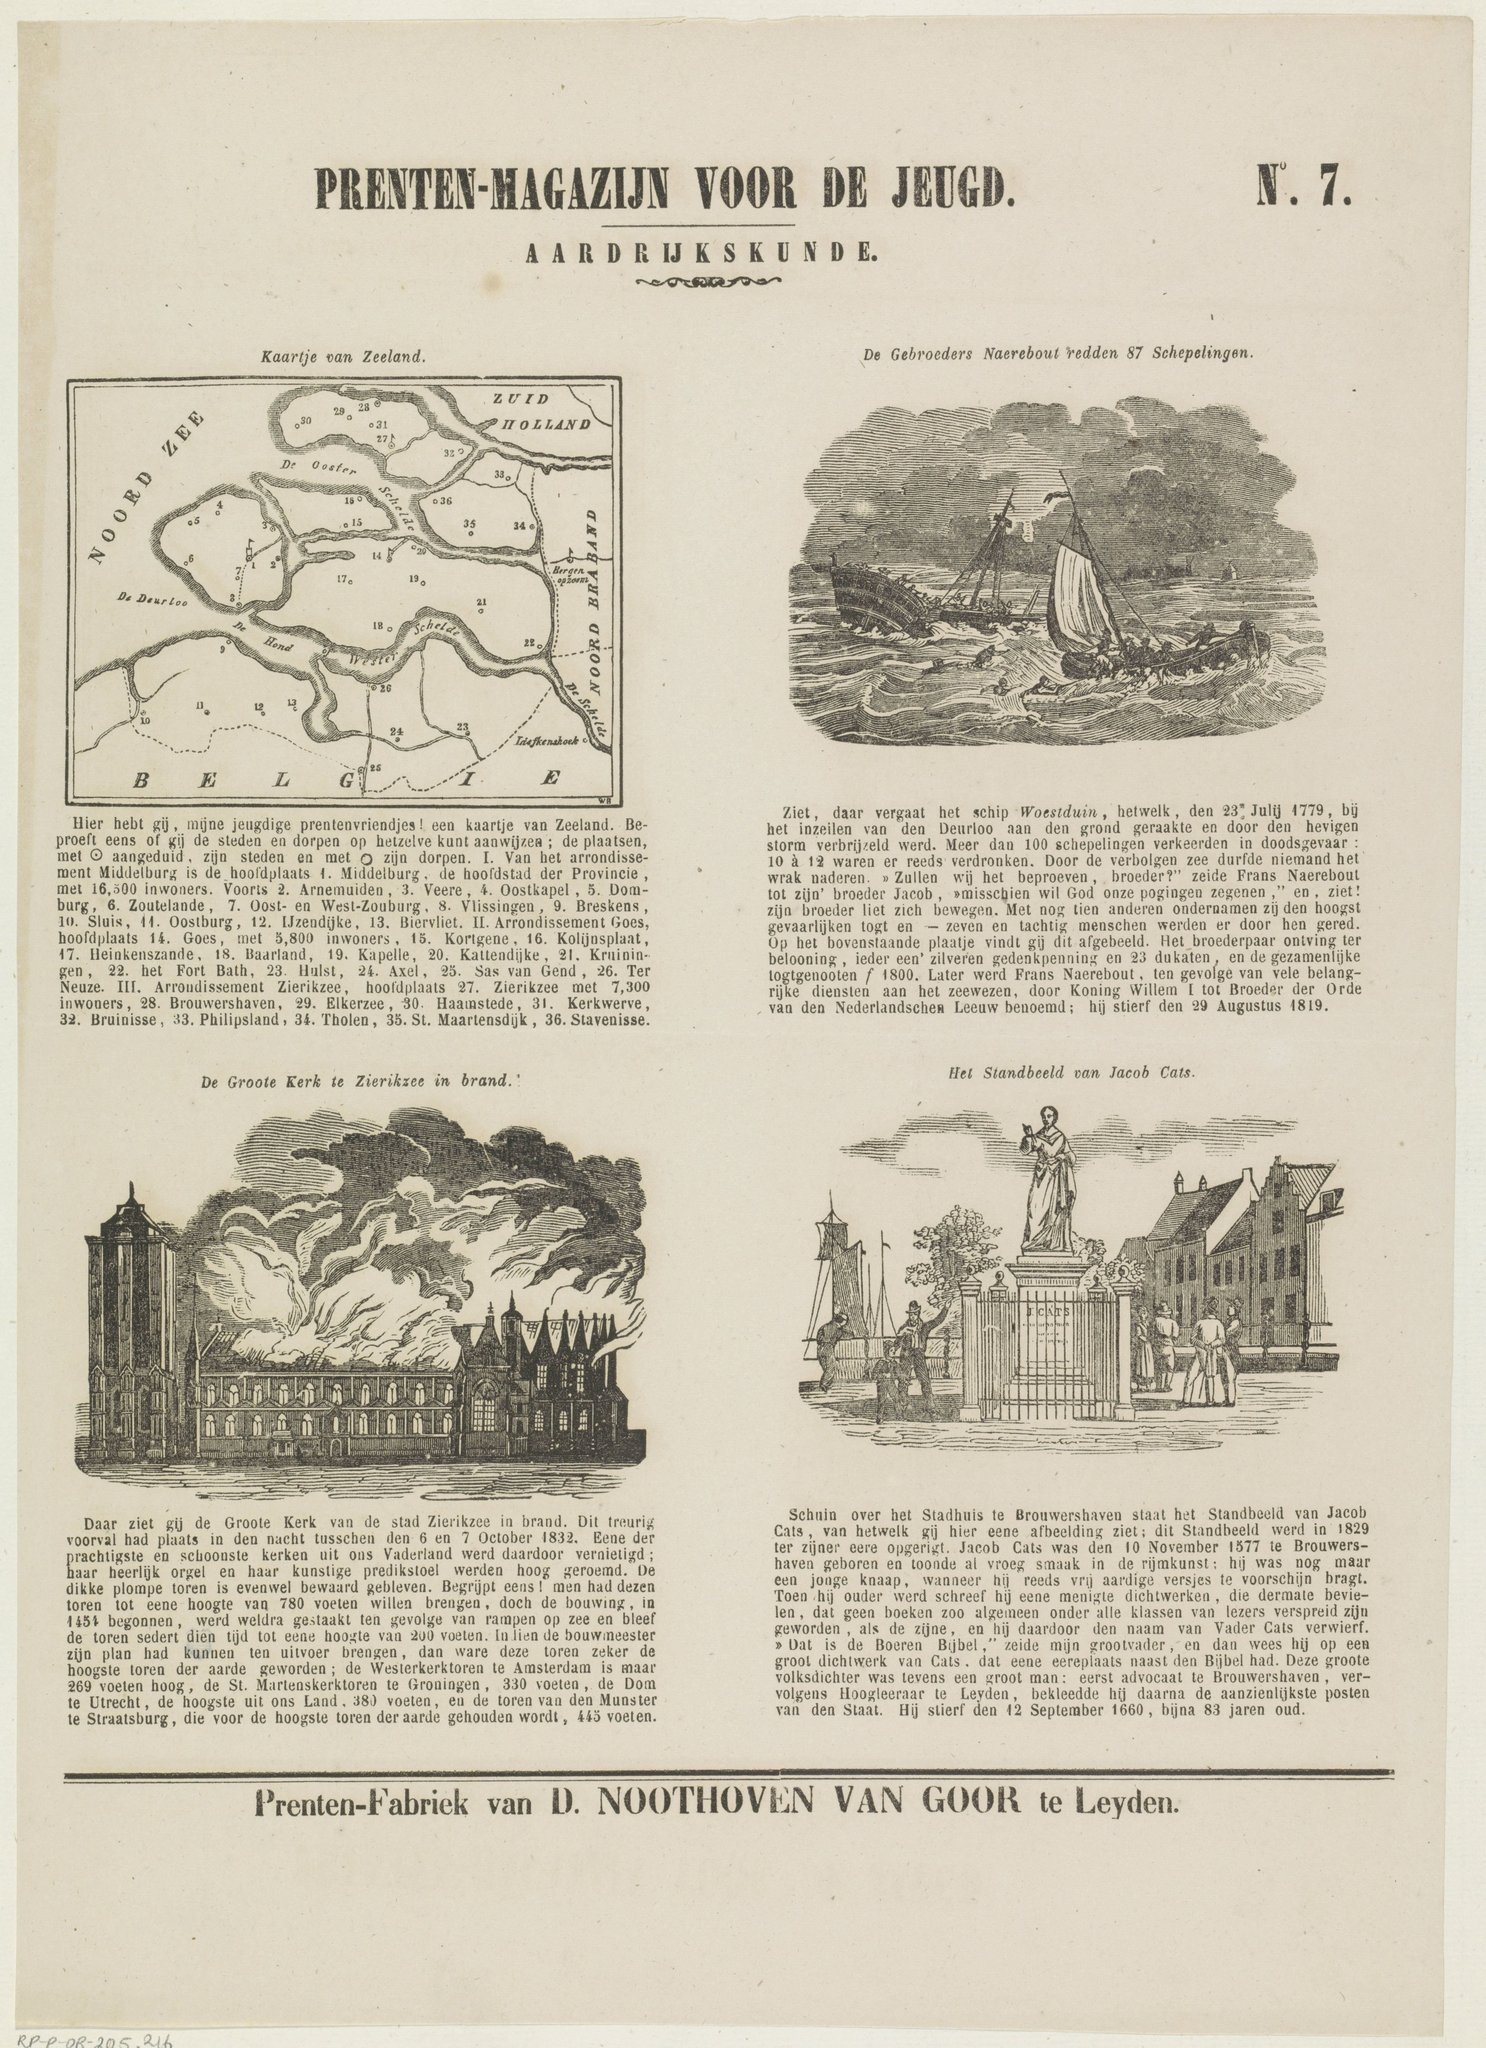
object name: popular print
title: Aardrijkskunde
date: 1850-1881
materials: paper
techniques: letterpress printing, engraving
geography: netherlands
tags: the hague, jacob cats (1577-1660), maps, atlases, shipwreck, monument, statue, zeeland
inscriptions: collector's mark: Lugt 2760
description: Blad met 4 voorstellingen over de provincie Zeeland met een kaart en belangrijke gebeurtenissen en monumenten: de gebroeders Naerebout redden 87 schipbreukelingen, de brand in de Sint-Lievensmonsterkerk te Zierikzee in 1832 en het standbeeld van Jacob Cats in Brouwershaven. Boven elke voorstelling een titel en onder elke voorstelling een onderschrift. Genummerd rechtsboven: No. 7.